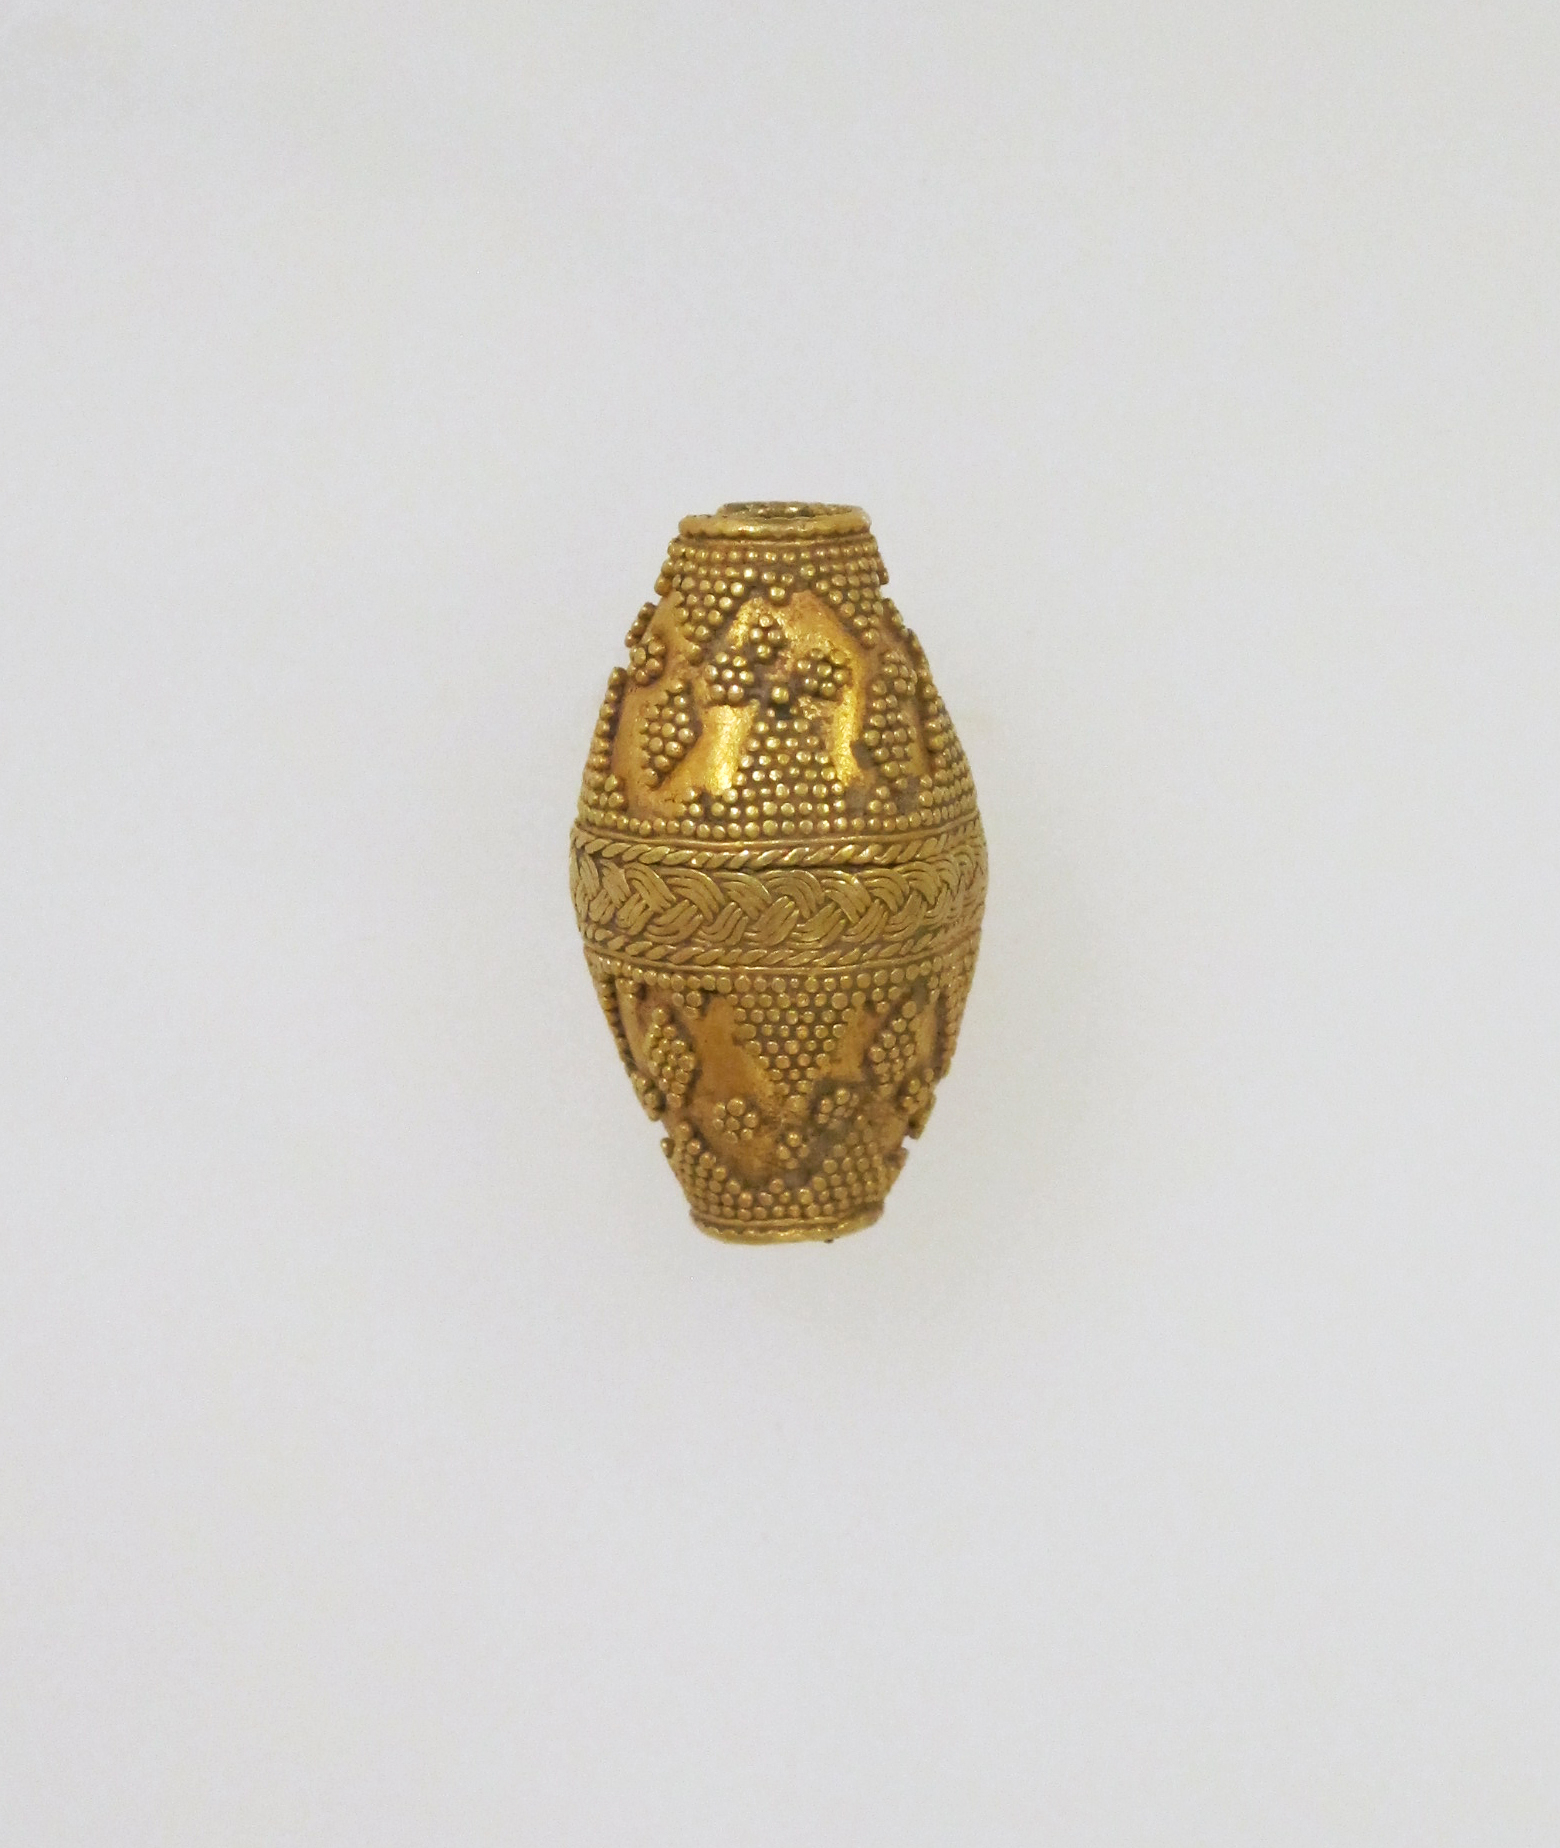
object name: bead ornamented with coarse granule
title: Bead ornamented with coarse granules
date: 600-401 BCE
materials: gold